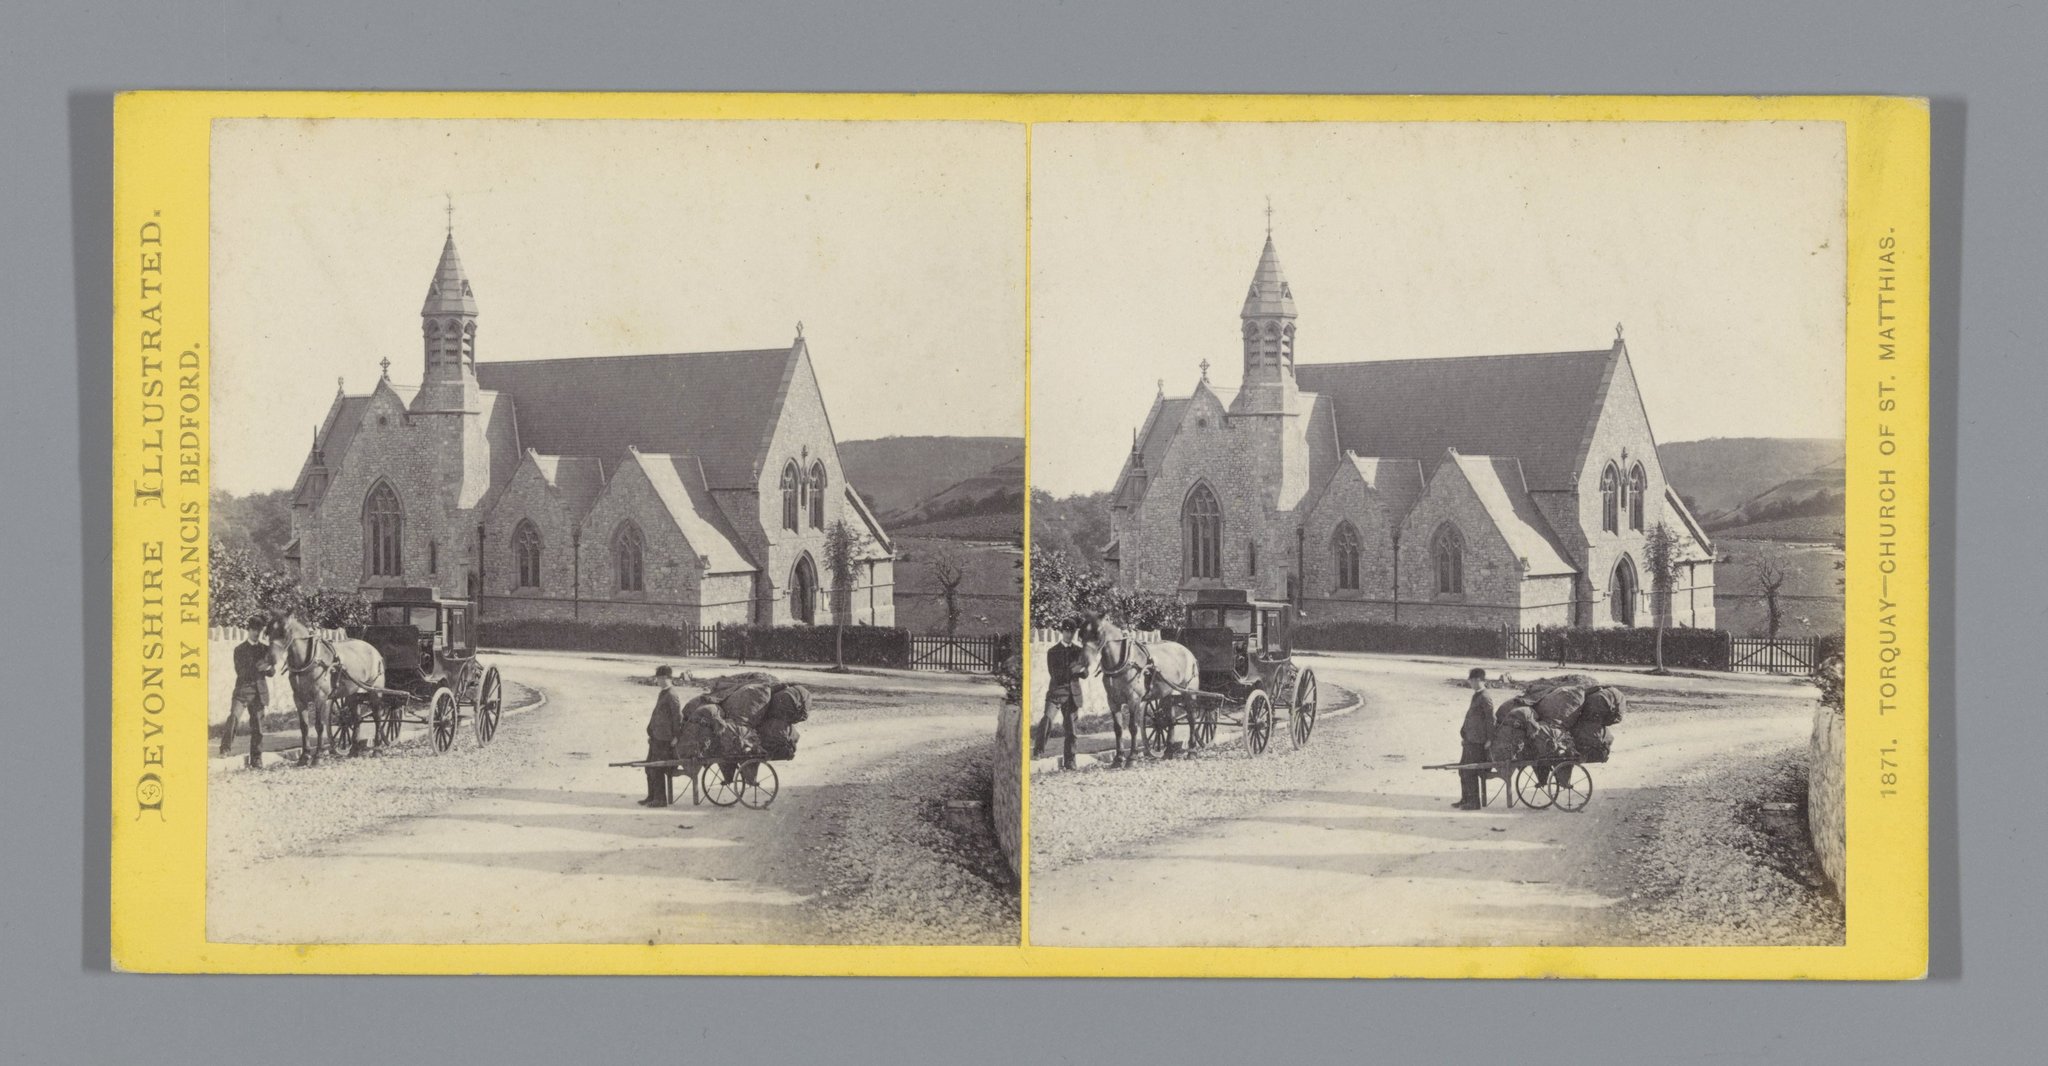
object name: stereograph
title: Exterieur van de St Matthias Church te Torquay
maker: francis bedford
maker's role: print maker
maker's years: 1815-1894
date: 1850-1880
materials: cardboard, photographic support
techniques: albumen print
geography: torquay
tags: four-wheeled, animal-drawn vehicle, e.g.: cab, carriage, coach, church (exterior)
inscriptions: number: ‘1871.’, inscription: ‘Devonshire Illustrated. by Francis Bedford.’